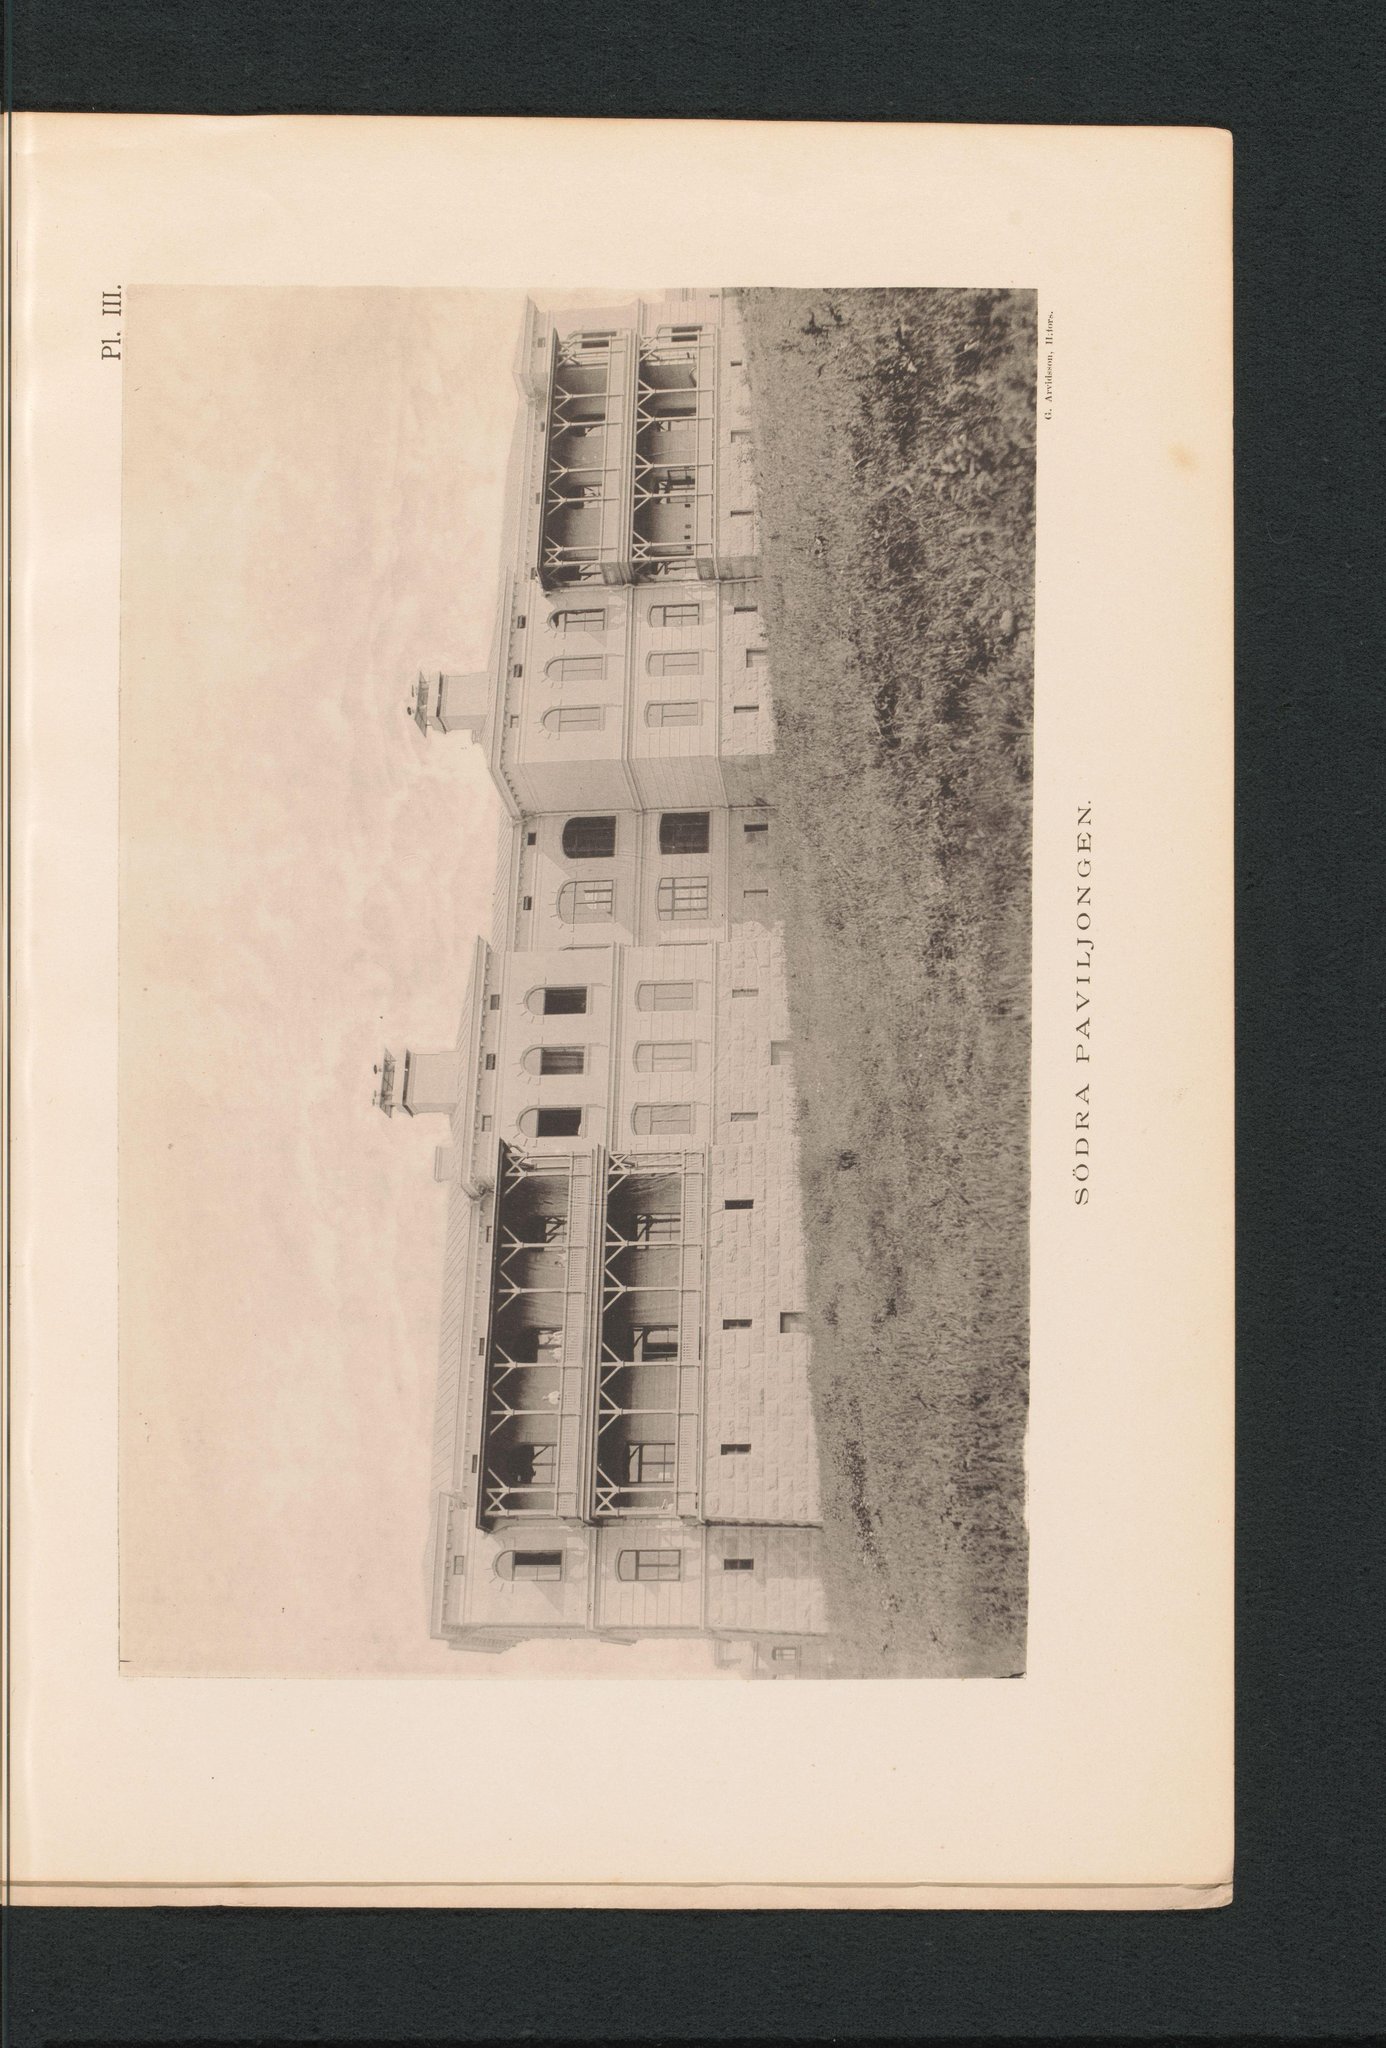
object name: photomechanical print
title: Gezicht op het zuidelijke paviljoen van een chirurgisch ziekenhuis in Helsinki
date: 1880-1890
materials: paper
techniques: photograph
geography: helsinki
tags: hospital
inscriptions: number: ‘Pl. III.’